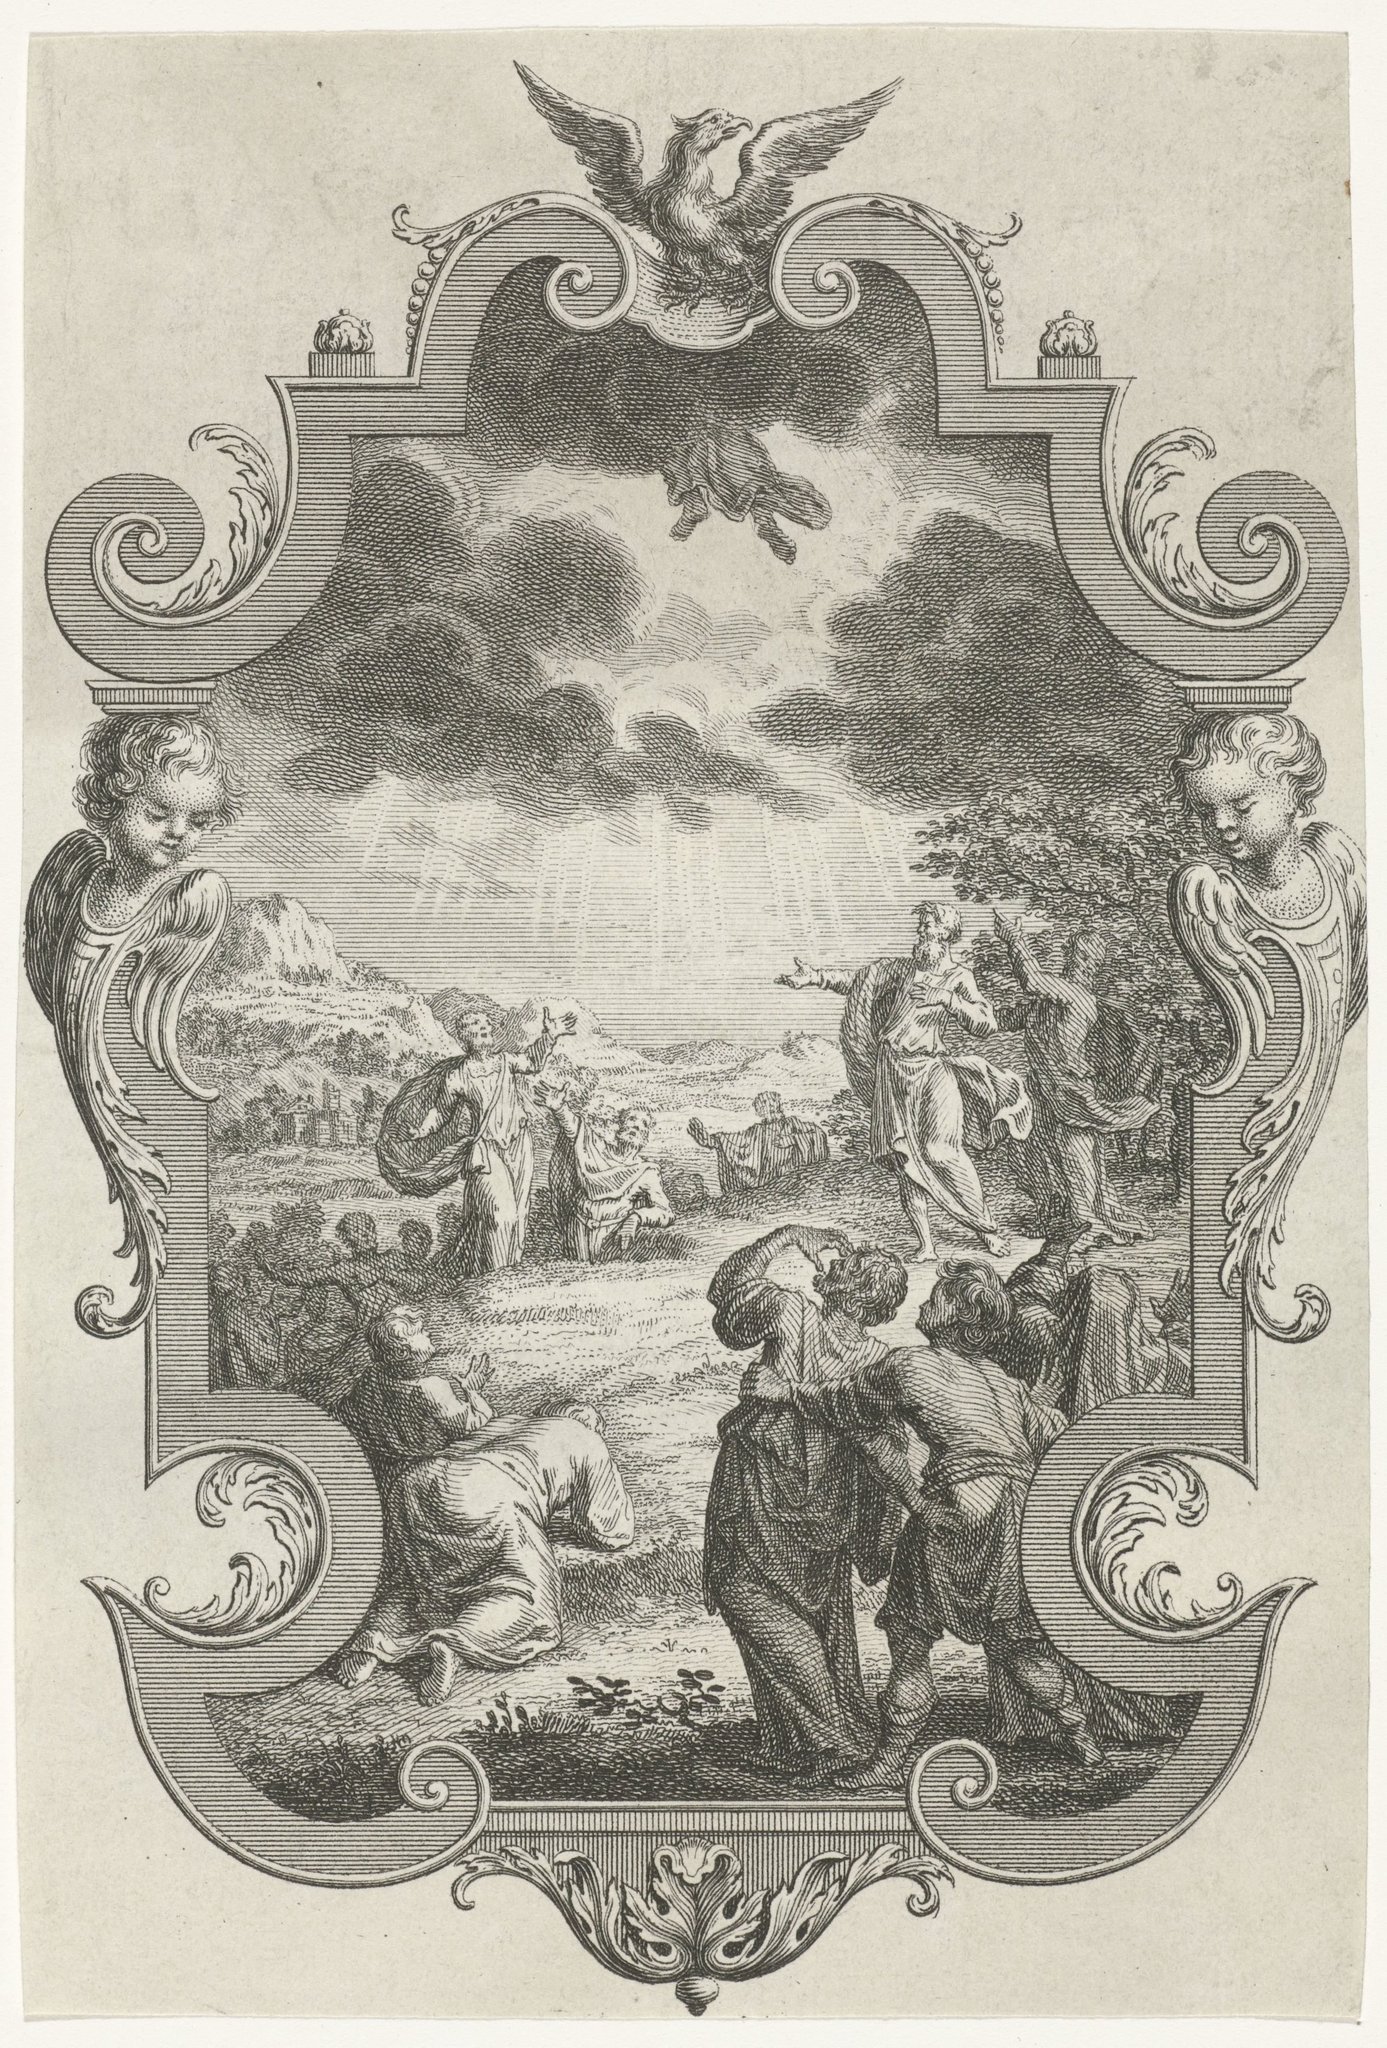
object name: print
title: Cartouche met de hemelvaart van Christus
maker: jan caspar philips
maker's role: draughtsman, print maker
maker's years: 1700-1775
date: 1736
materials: paper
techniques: engraving, etching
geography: amsterdam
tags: the ascension (christ surrounded by radiant light or in a mandorla), predatory birds: eagle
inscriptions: collector's mark: Lugt 2228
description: Landschap met de hemelvaart van Christus. Omstanders kijken vol verwondering toe. De voorstelling is gevat in een cartouche dat wordt bekroond door een adelaar.